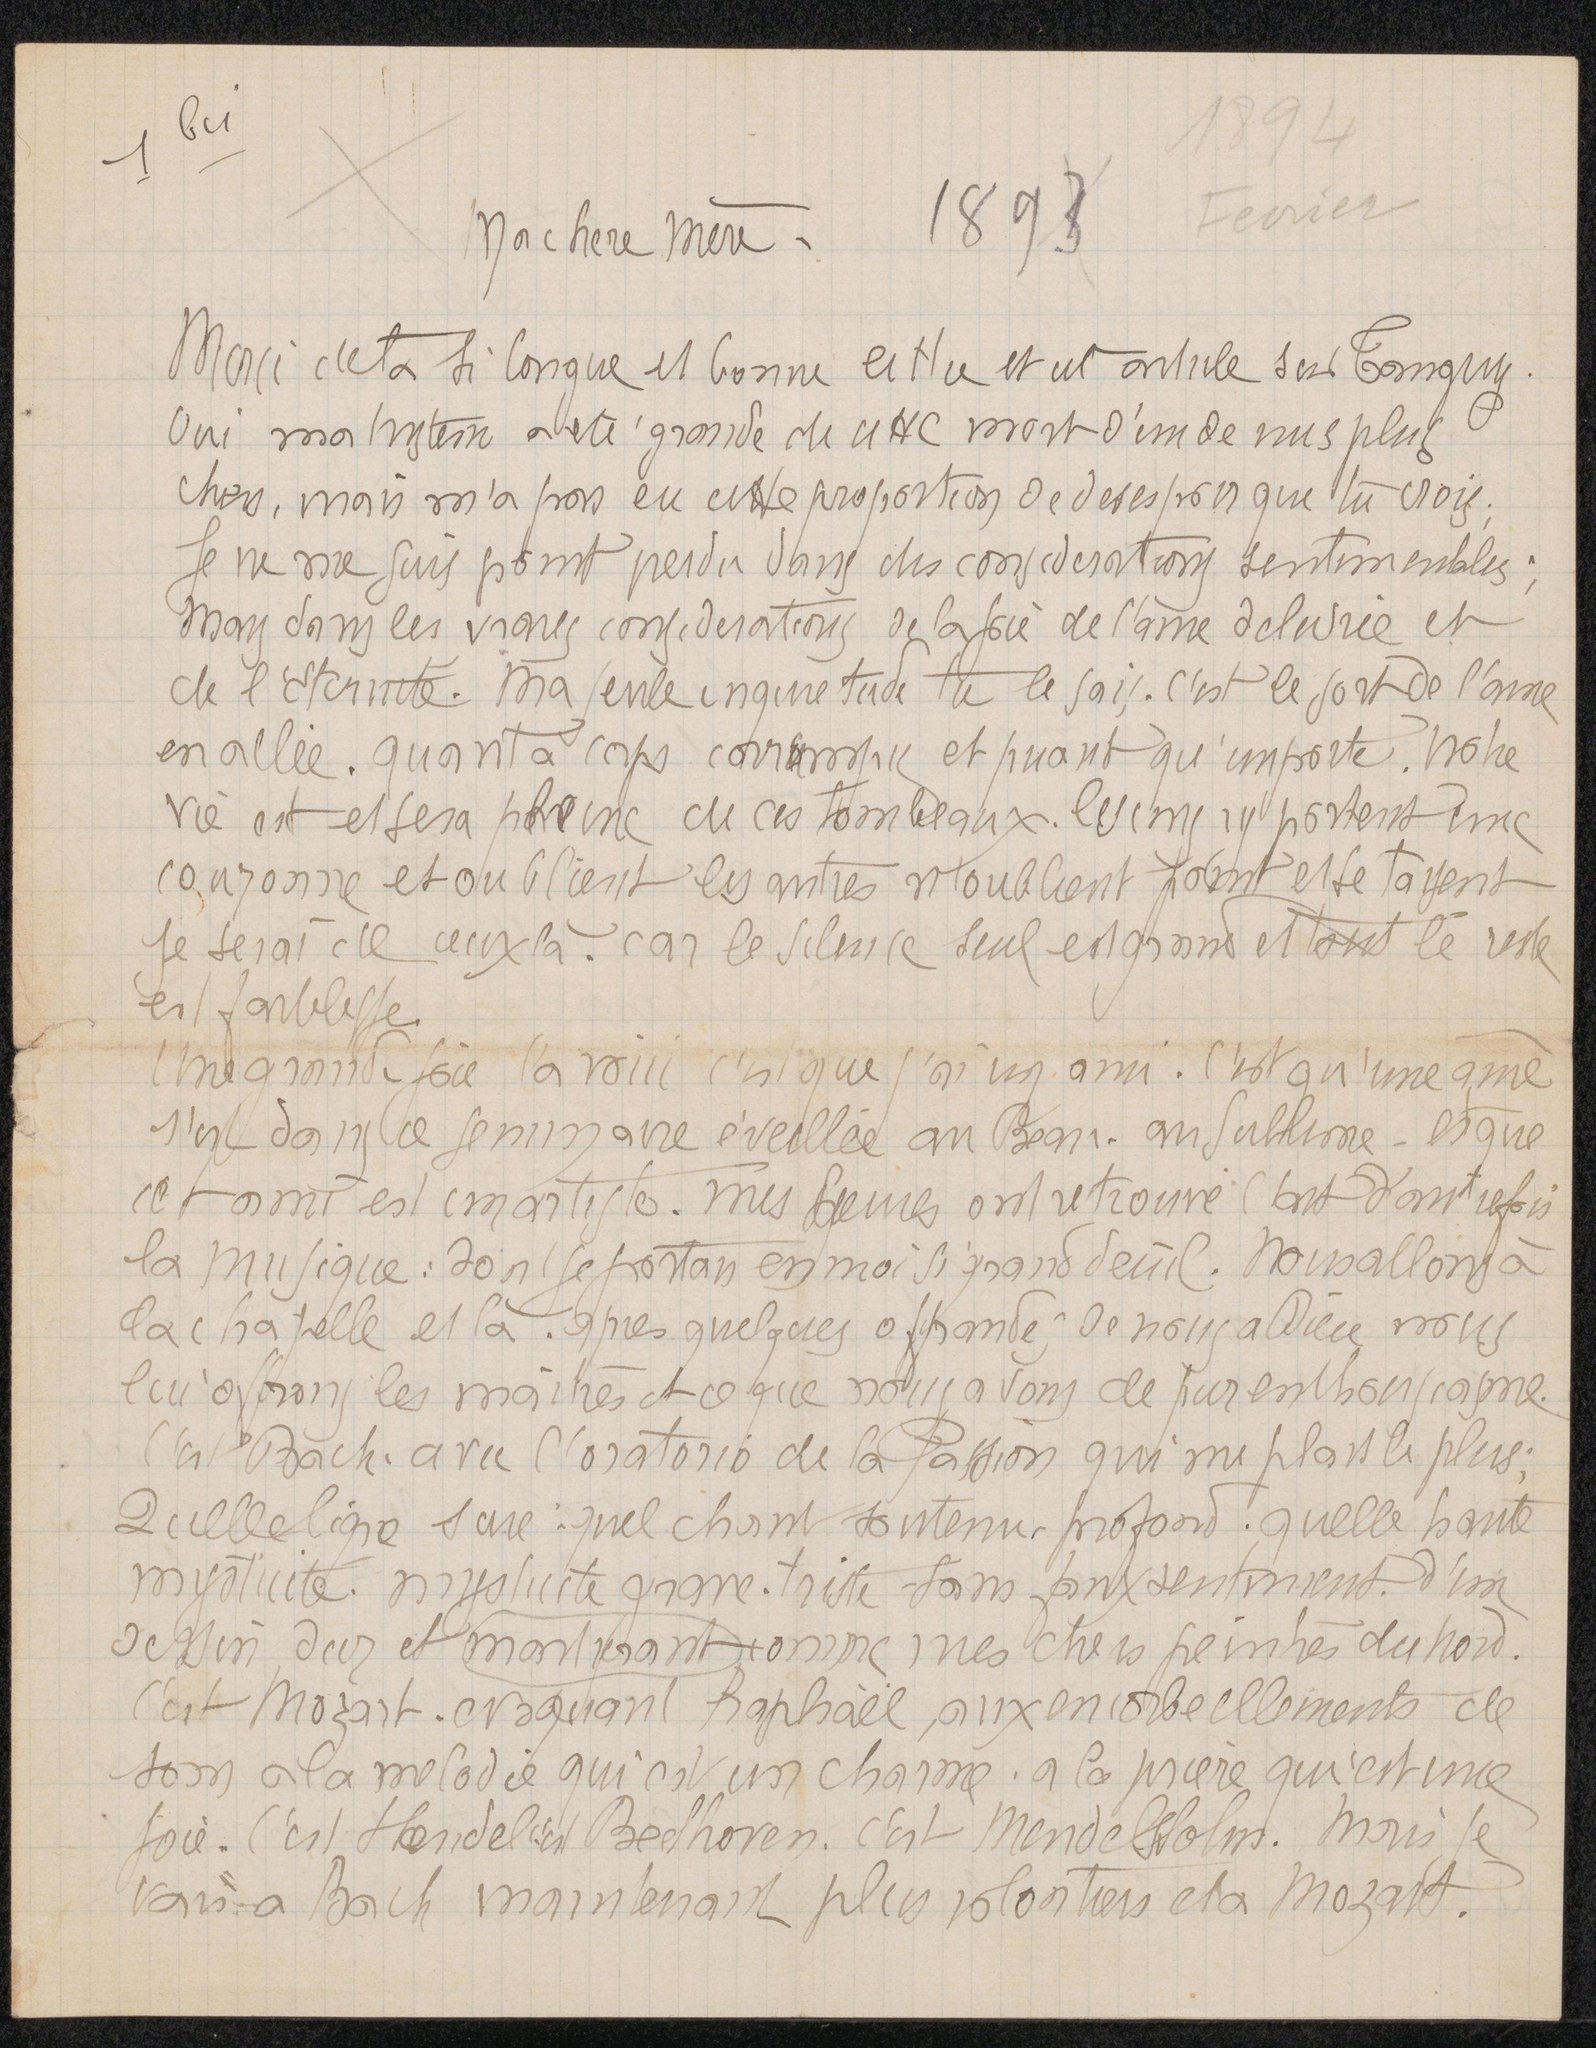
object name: letter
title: Brief aan Héloïse Bernard-Bodin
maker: émile bernard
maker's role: print maker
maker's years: 1868-1941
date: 1878-1941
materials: ink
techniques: pen, writing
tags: héloïse bernard-bodin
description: Brief gedateerd 1893 [3 doorgehaald] en 1894 Fevrier in latere hand.